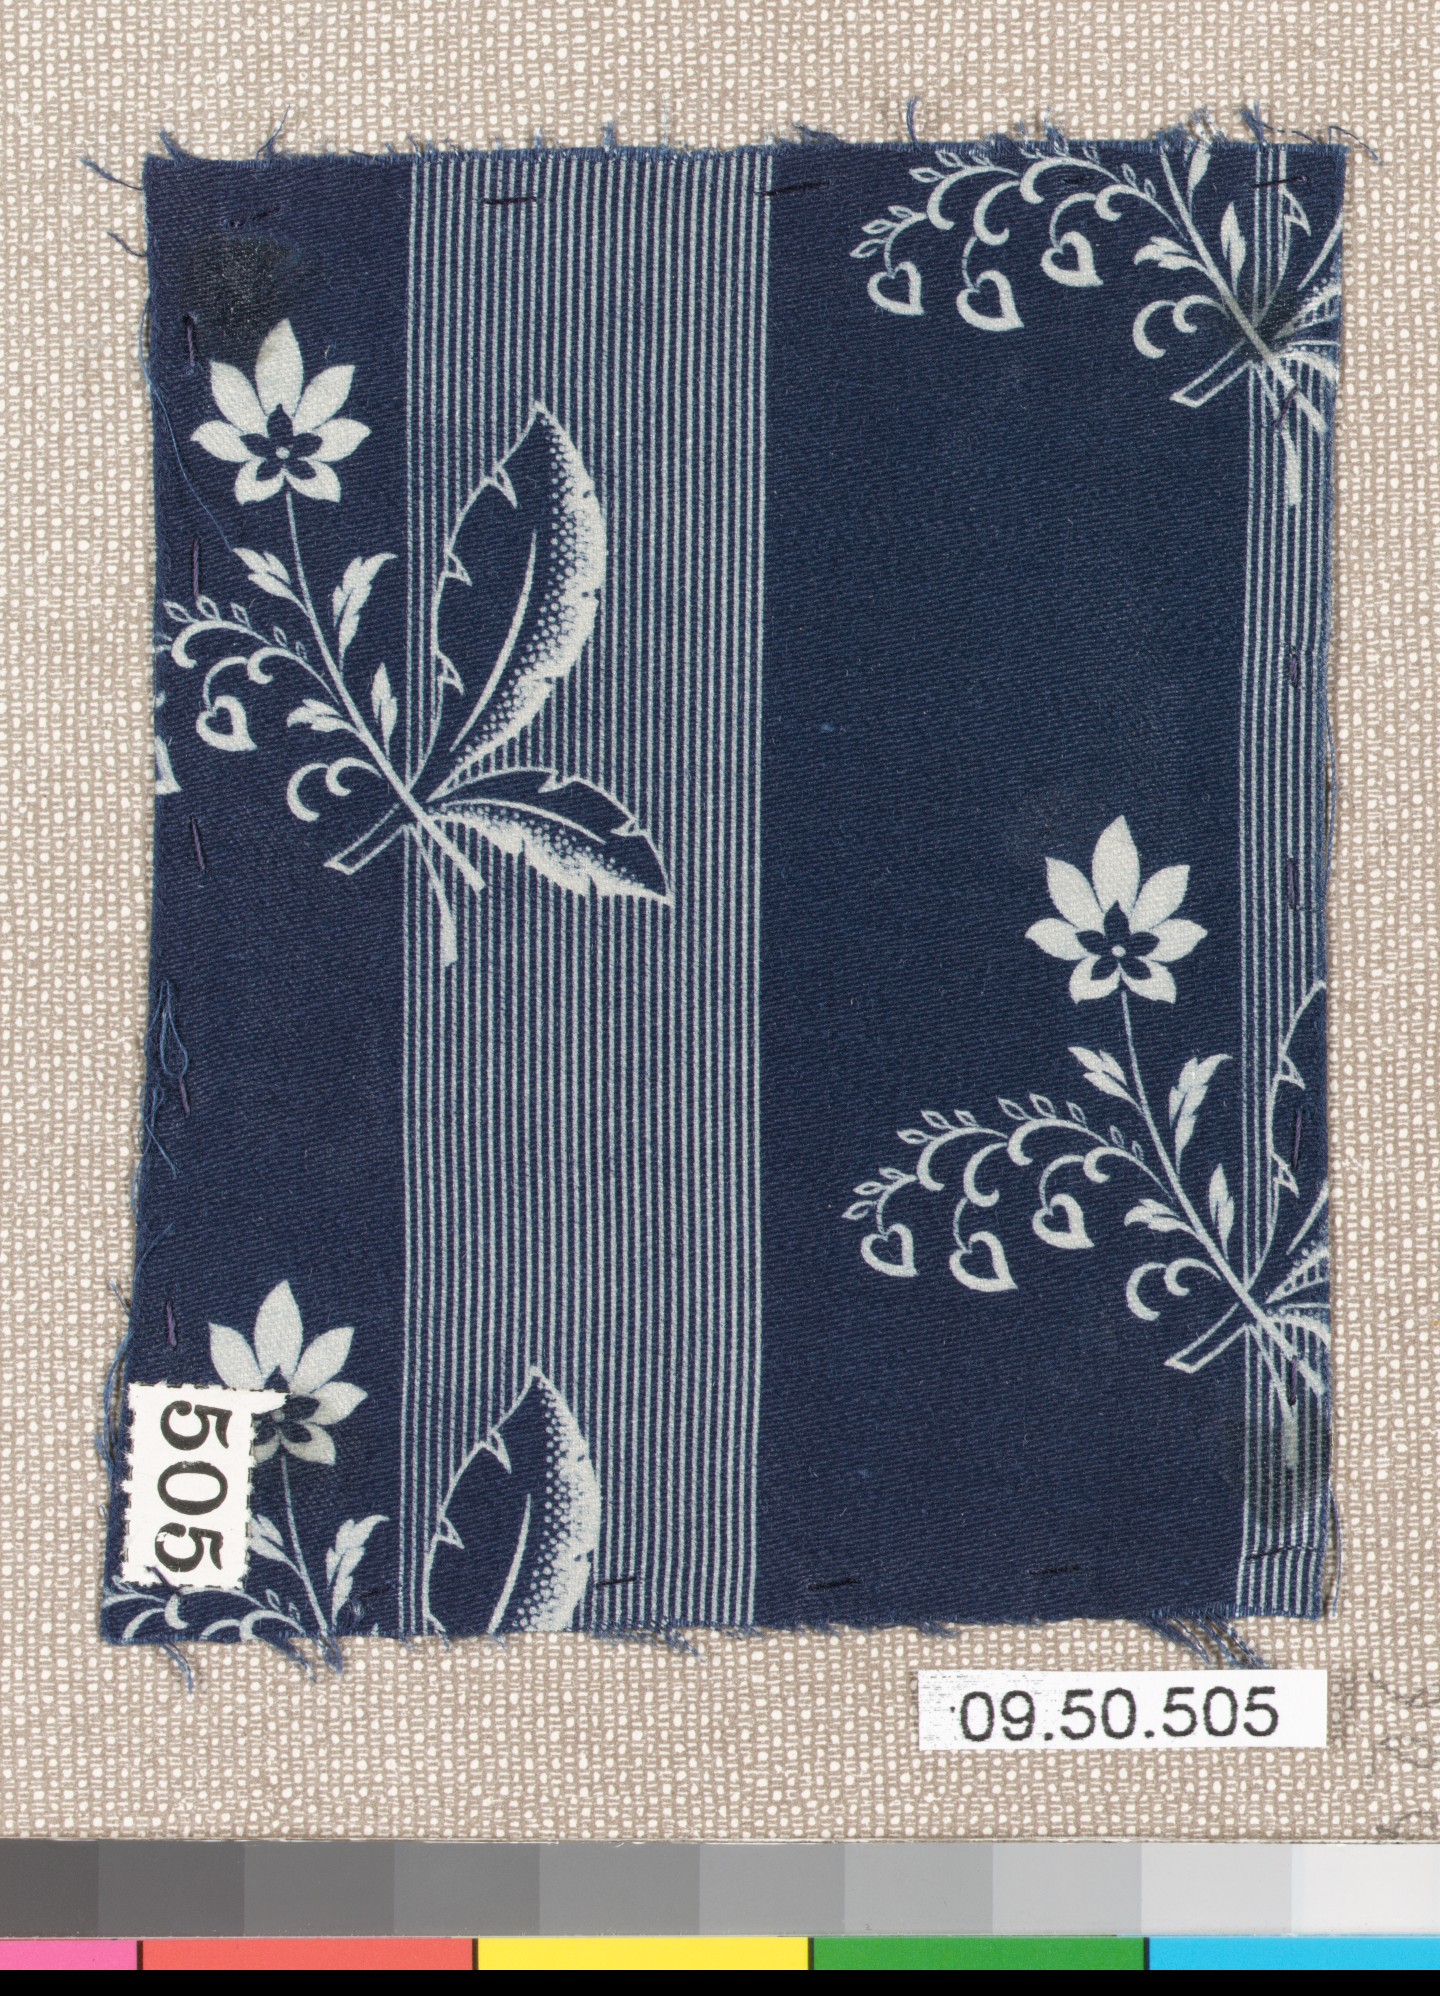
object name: piece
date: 1801-1900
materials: cotton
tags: flowers,leaves